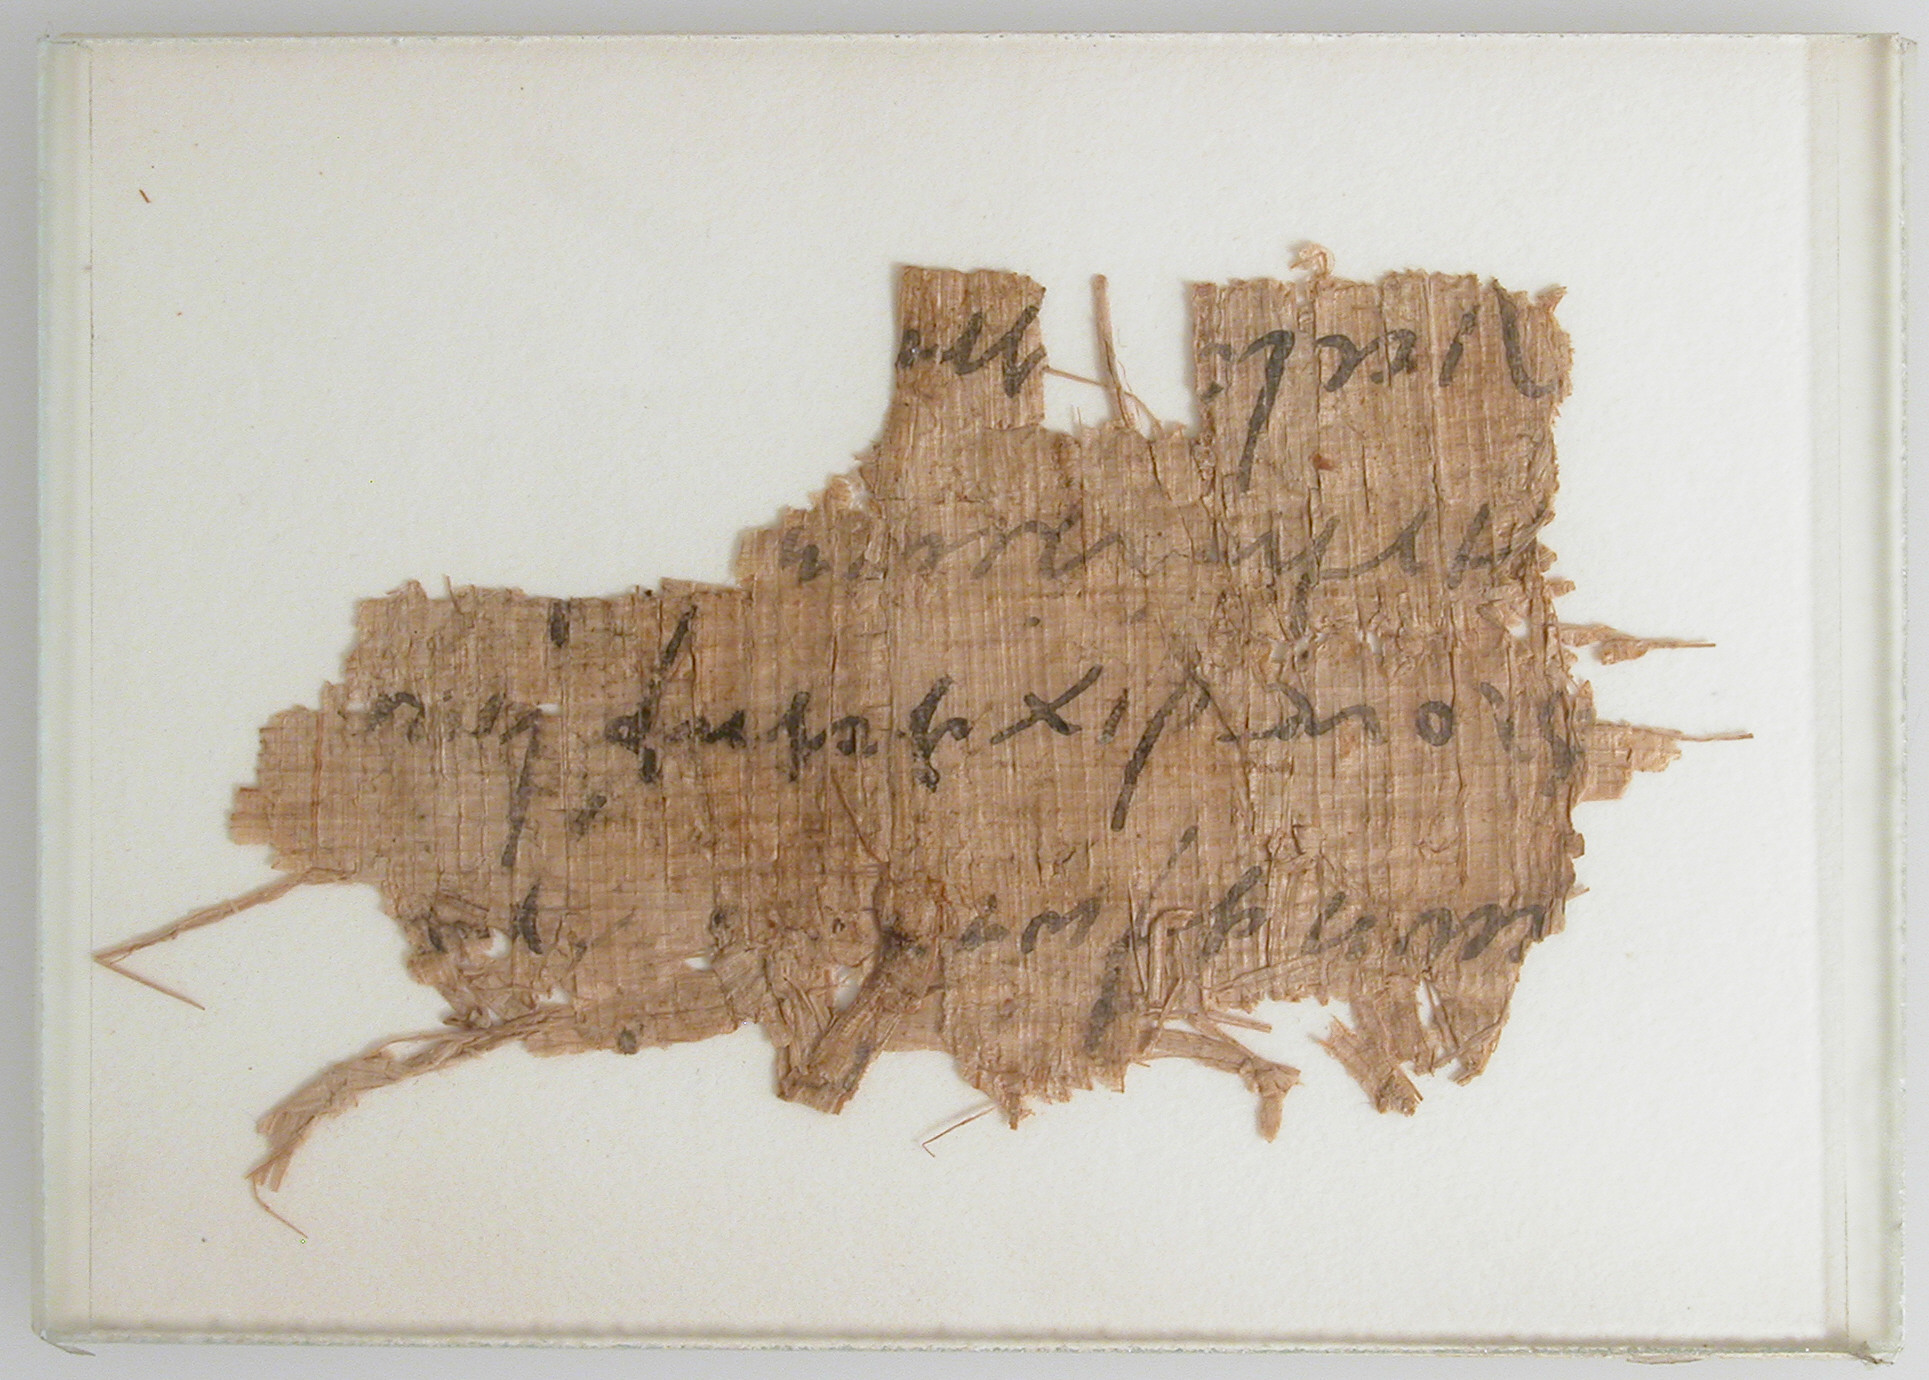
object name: fragment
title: Papyrus Fragment of a Letter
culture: coptic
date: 600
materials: ink, papyrus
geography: egypt